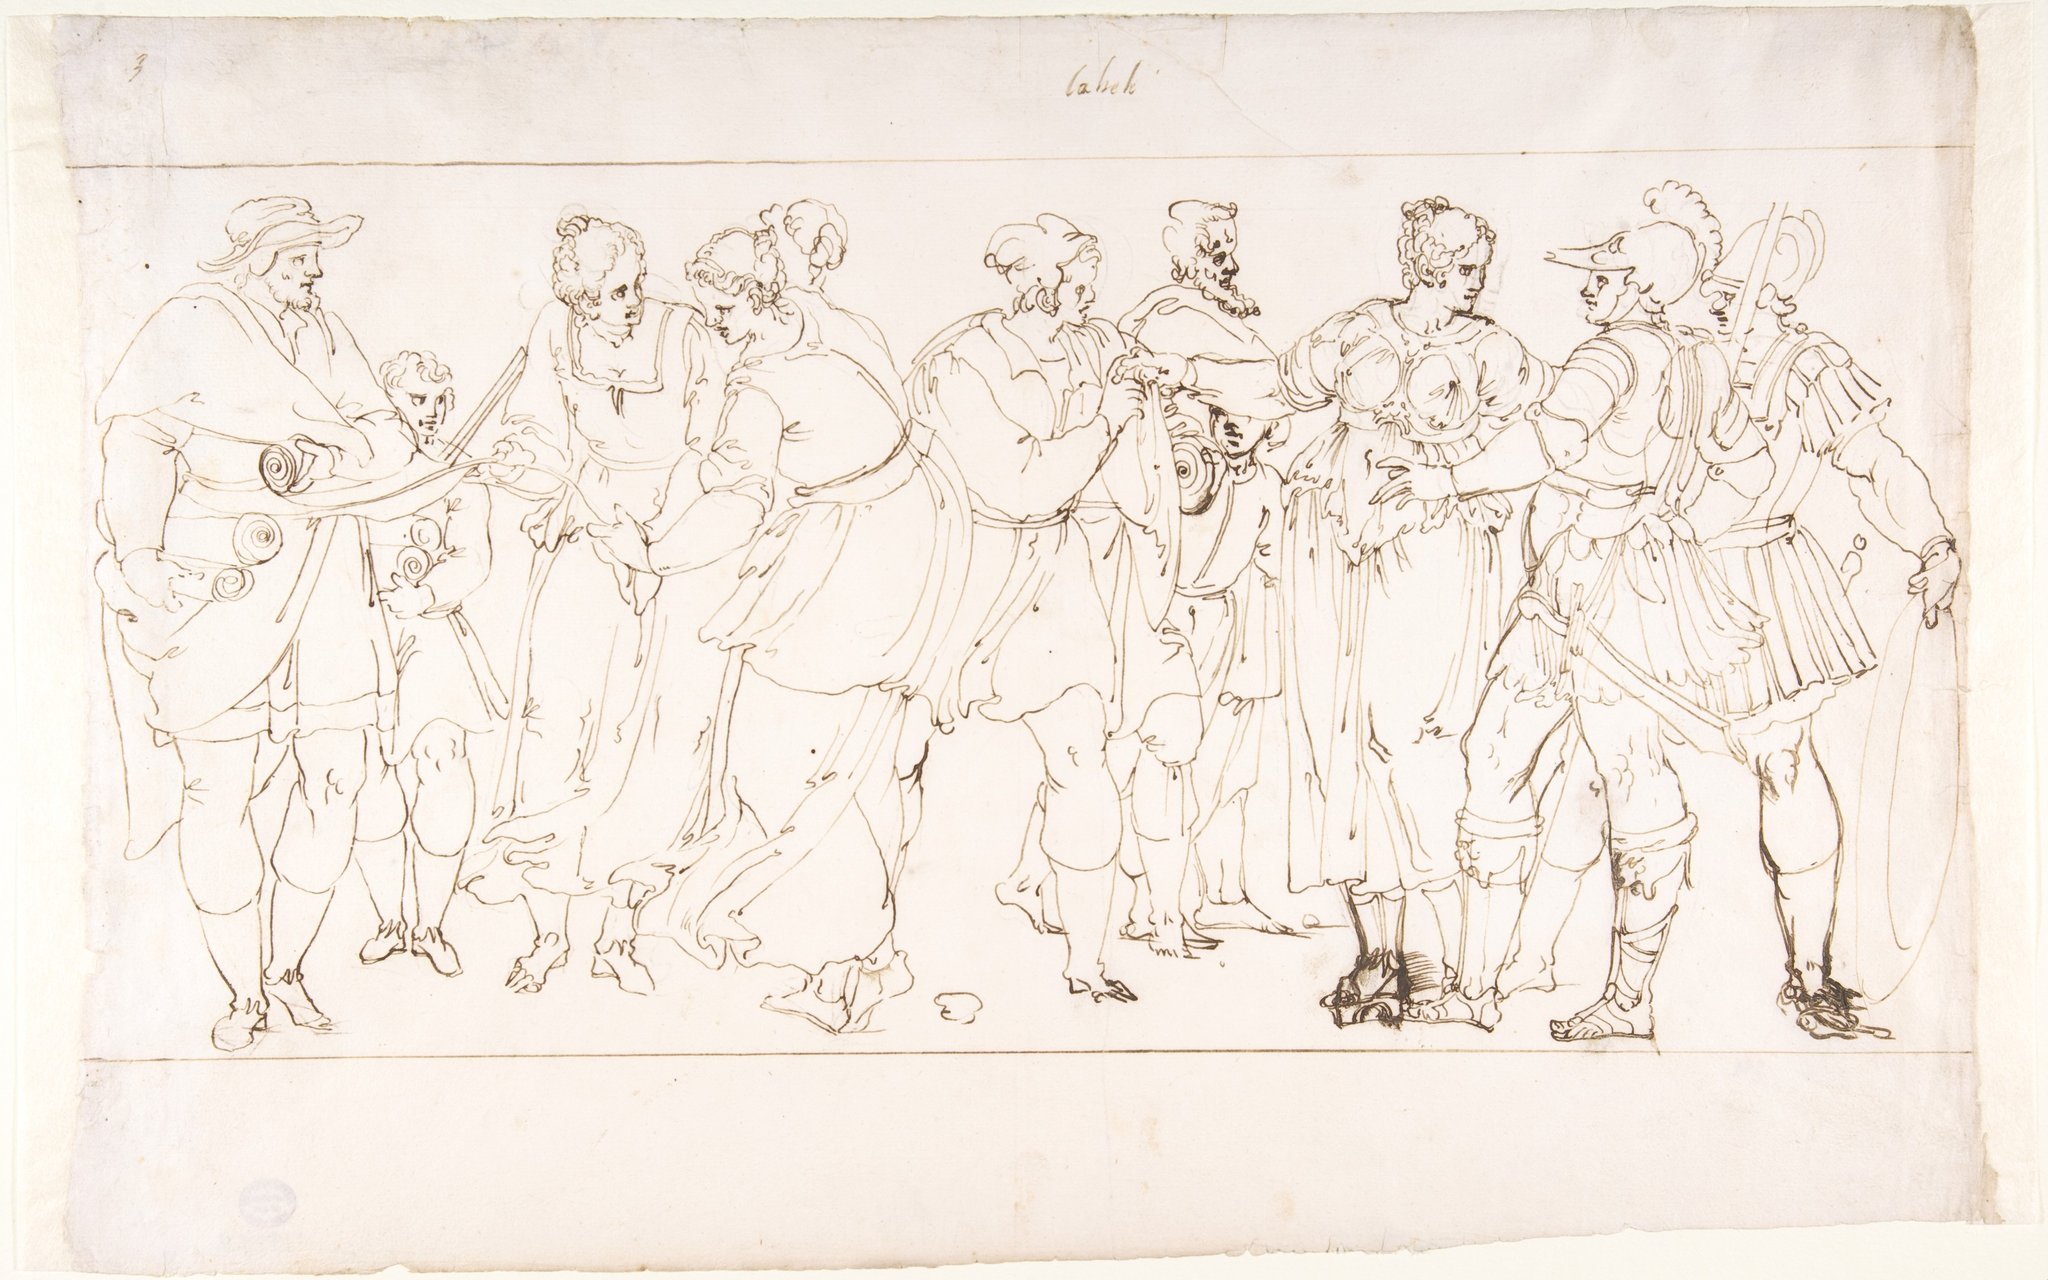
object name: drawing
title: Vendor of Horoscopes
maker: ercole setti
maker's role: artist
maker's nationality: italian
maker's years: 1500-1600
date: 1501-1600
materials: chalk, ink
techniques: pen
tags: men,women